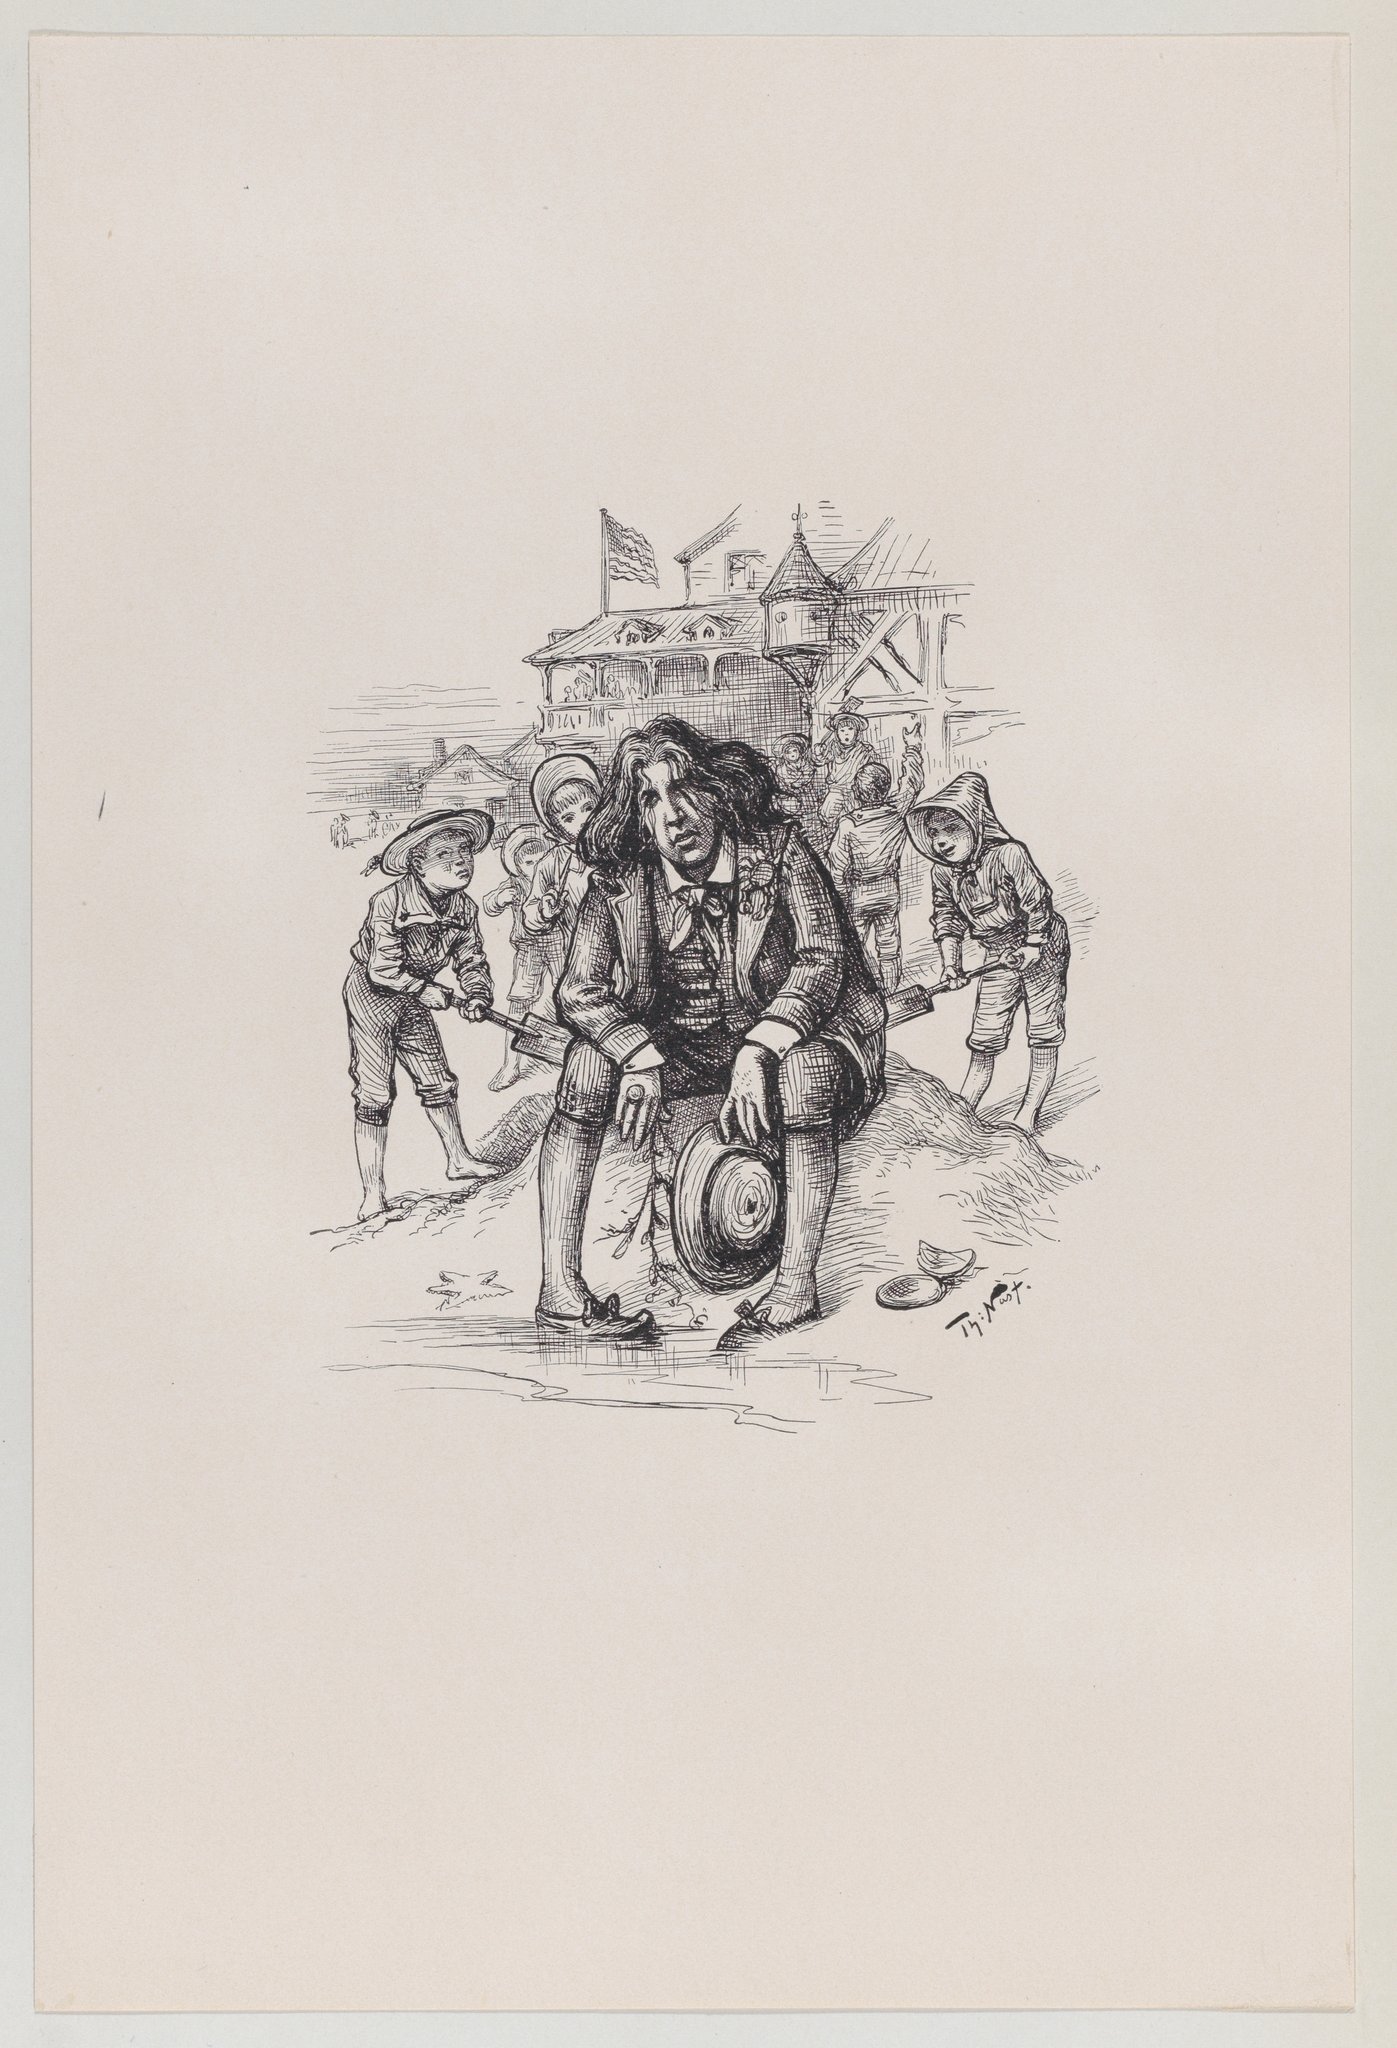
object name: print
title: Oscar at the Sea-Shore (published in "Harper's Bazar," August 26, 1882)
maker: thomas nast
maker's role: artist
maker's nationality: american, born germany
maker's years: 1840-1902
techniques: relief print